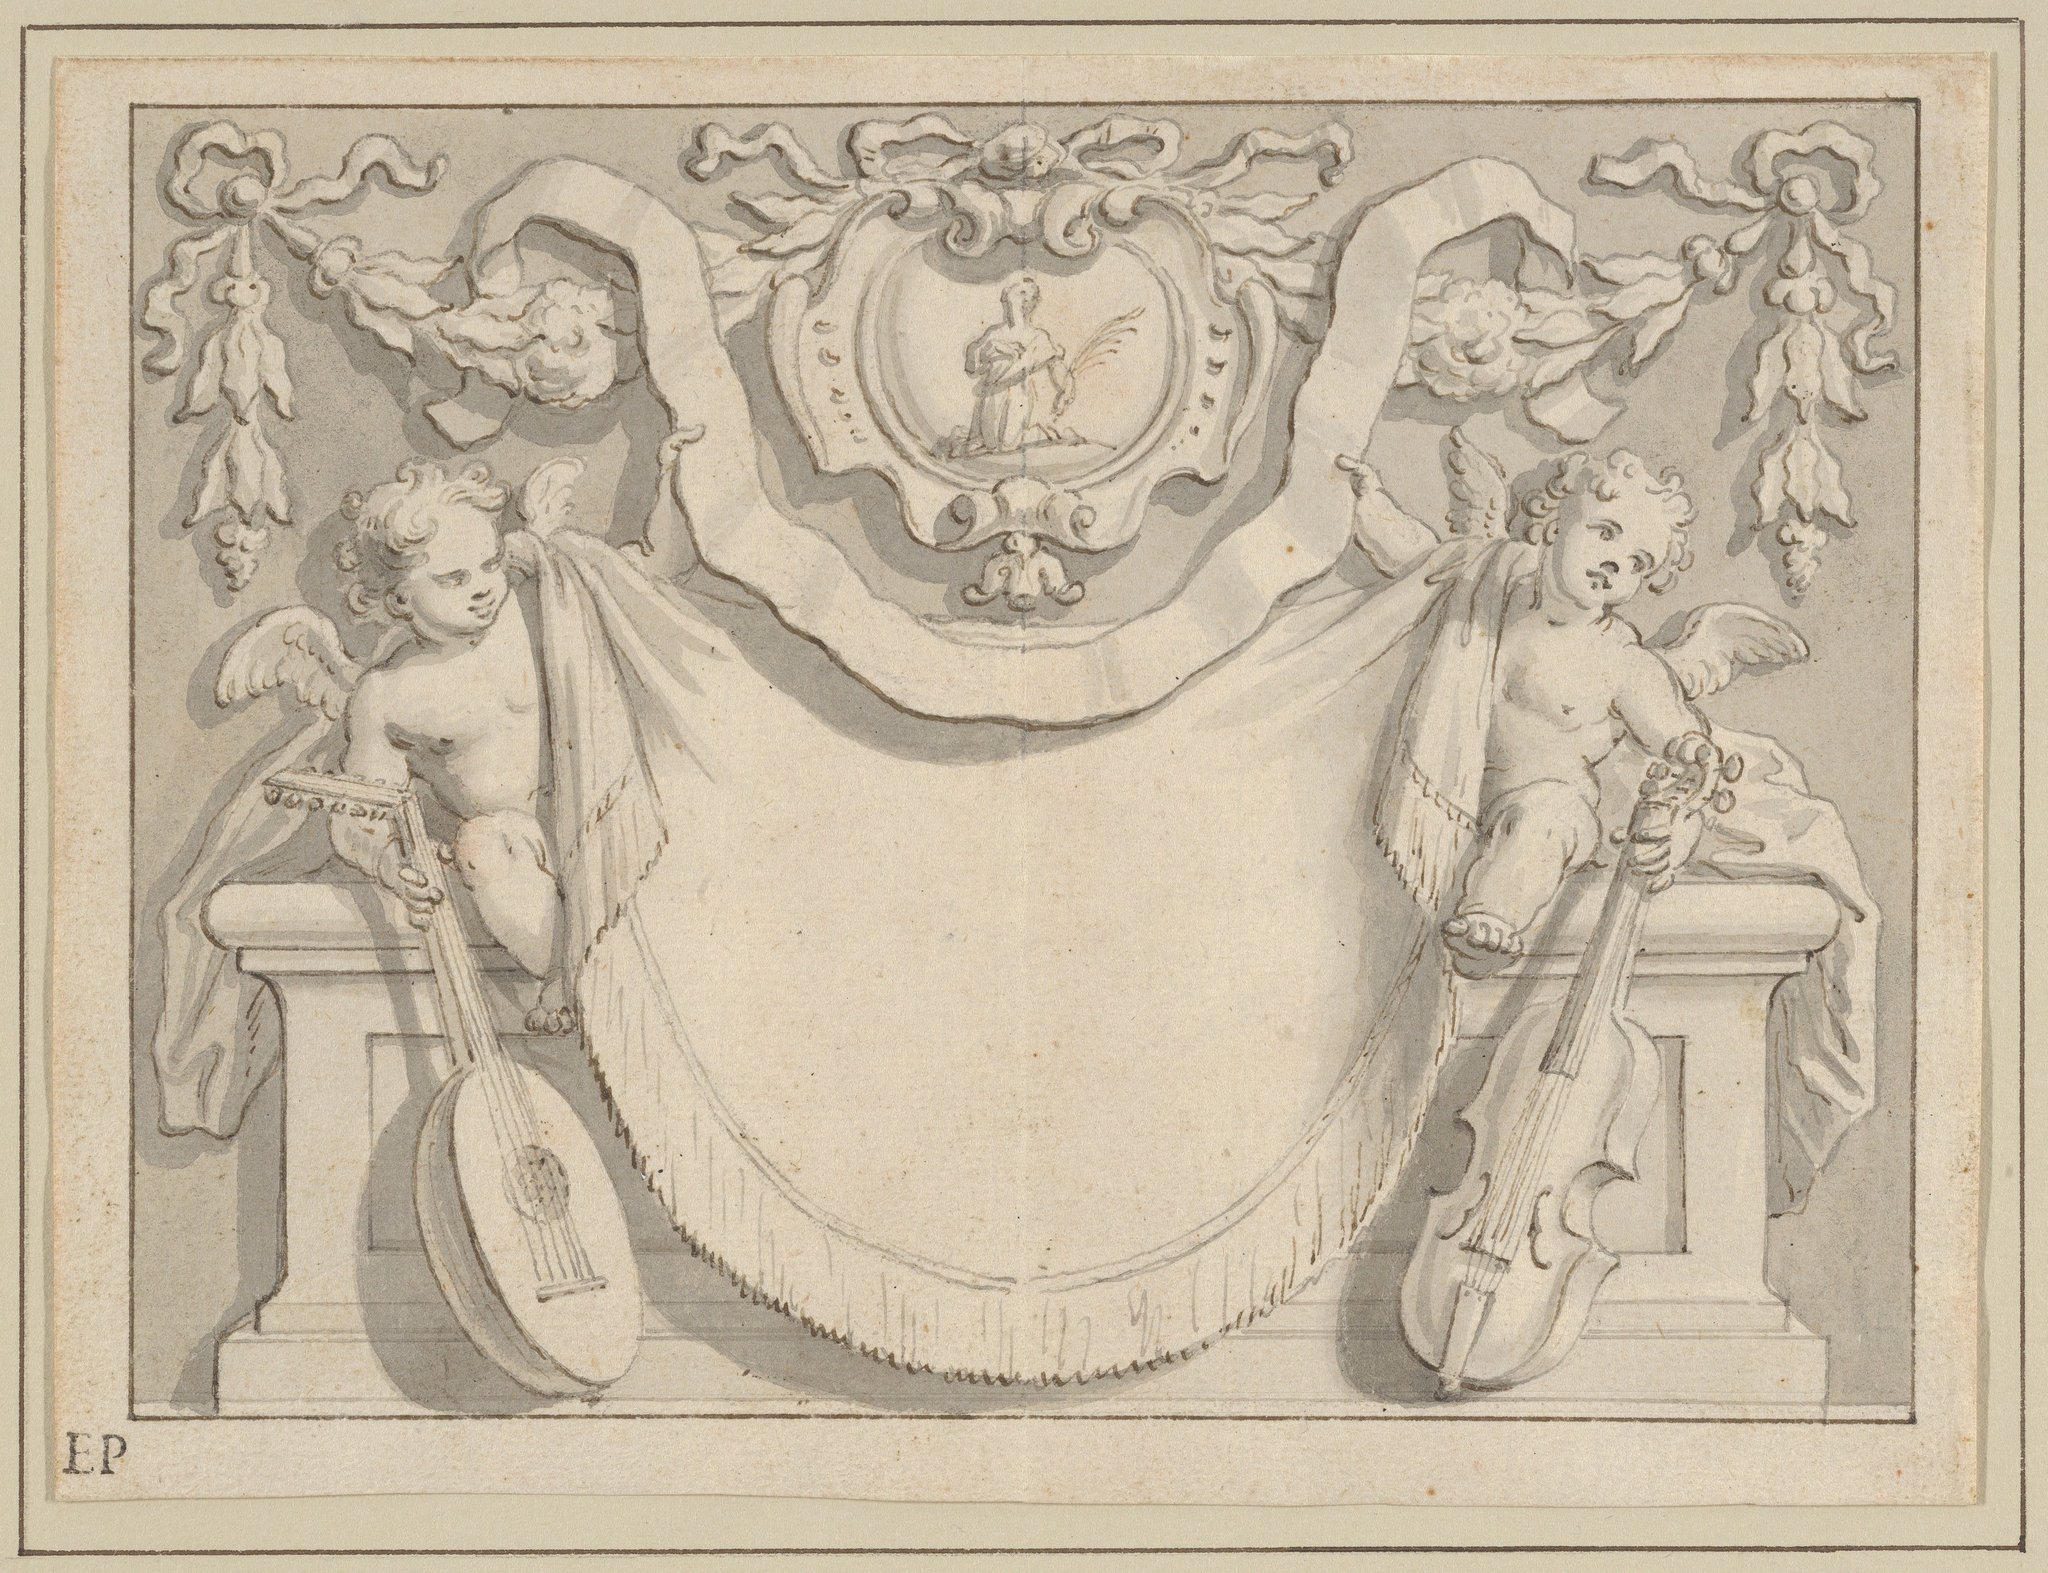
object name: drawing ornament architecture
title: Design for a Cartouche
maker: anonymous, italian, 17th century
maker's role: artist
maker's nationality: italian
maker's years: 1600-1700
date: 1601-1700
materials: ink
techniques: pen, wash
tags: musical instruments,cartouches